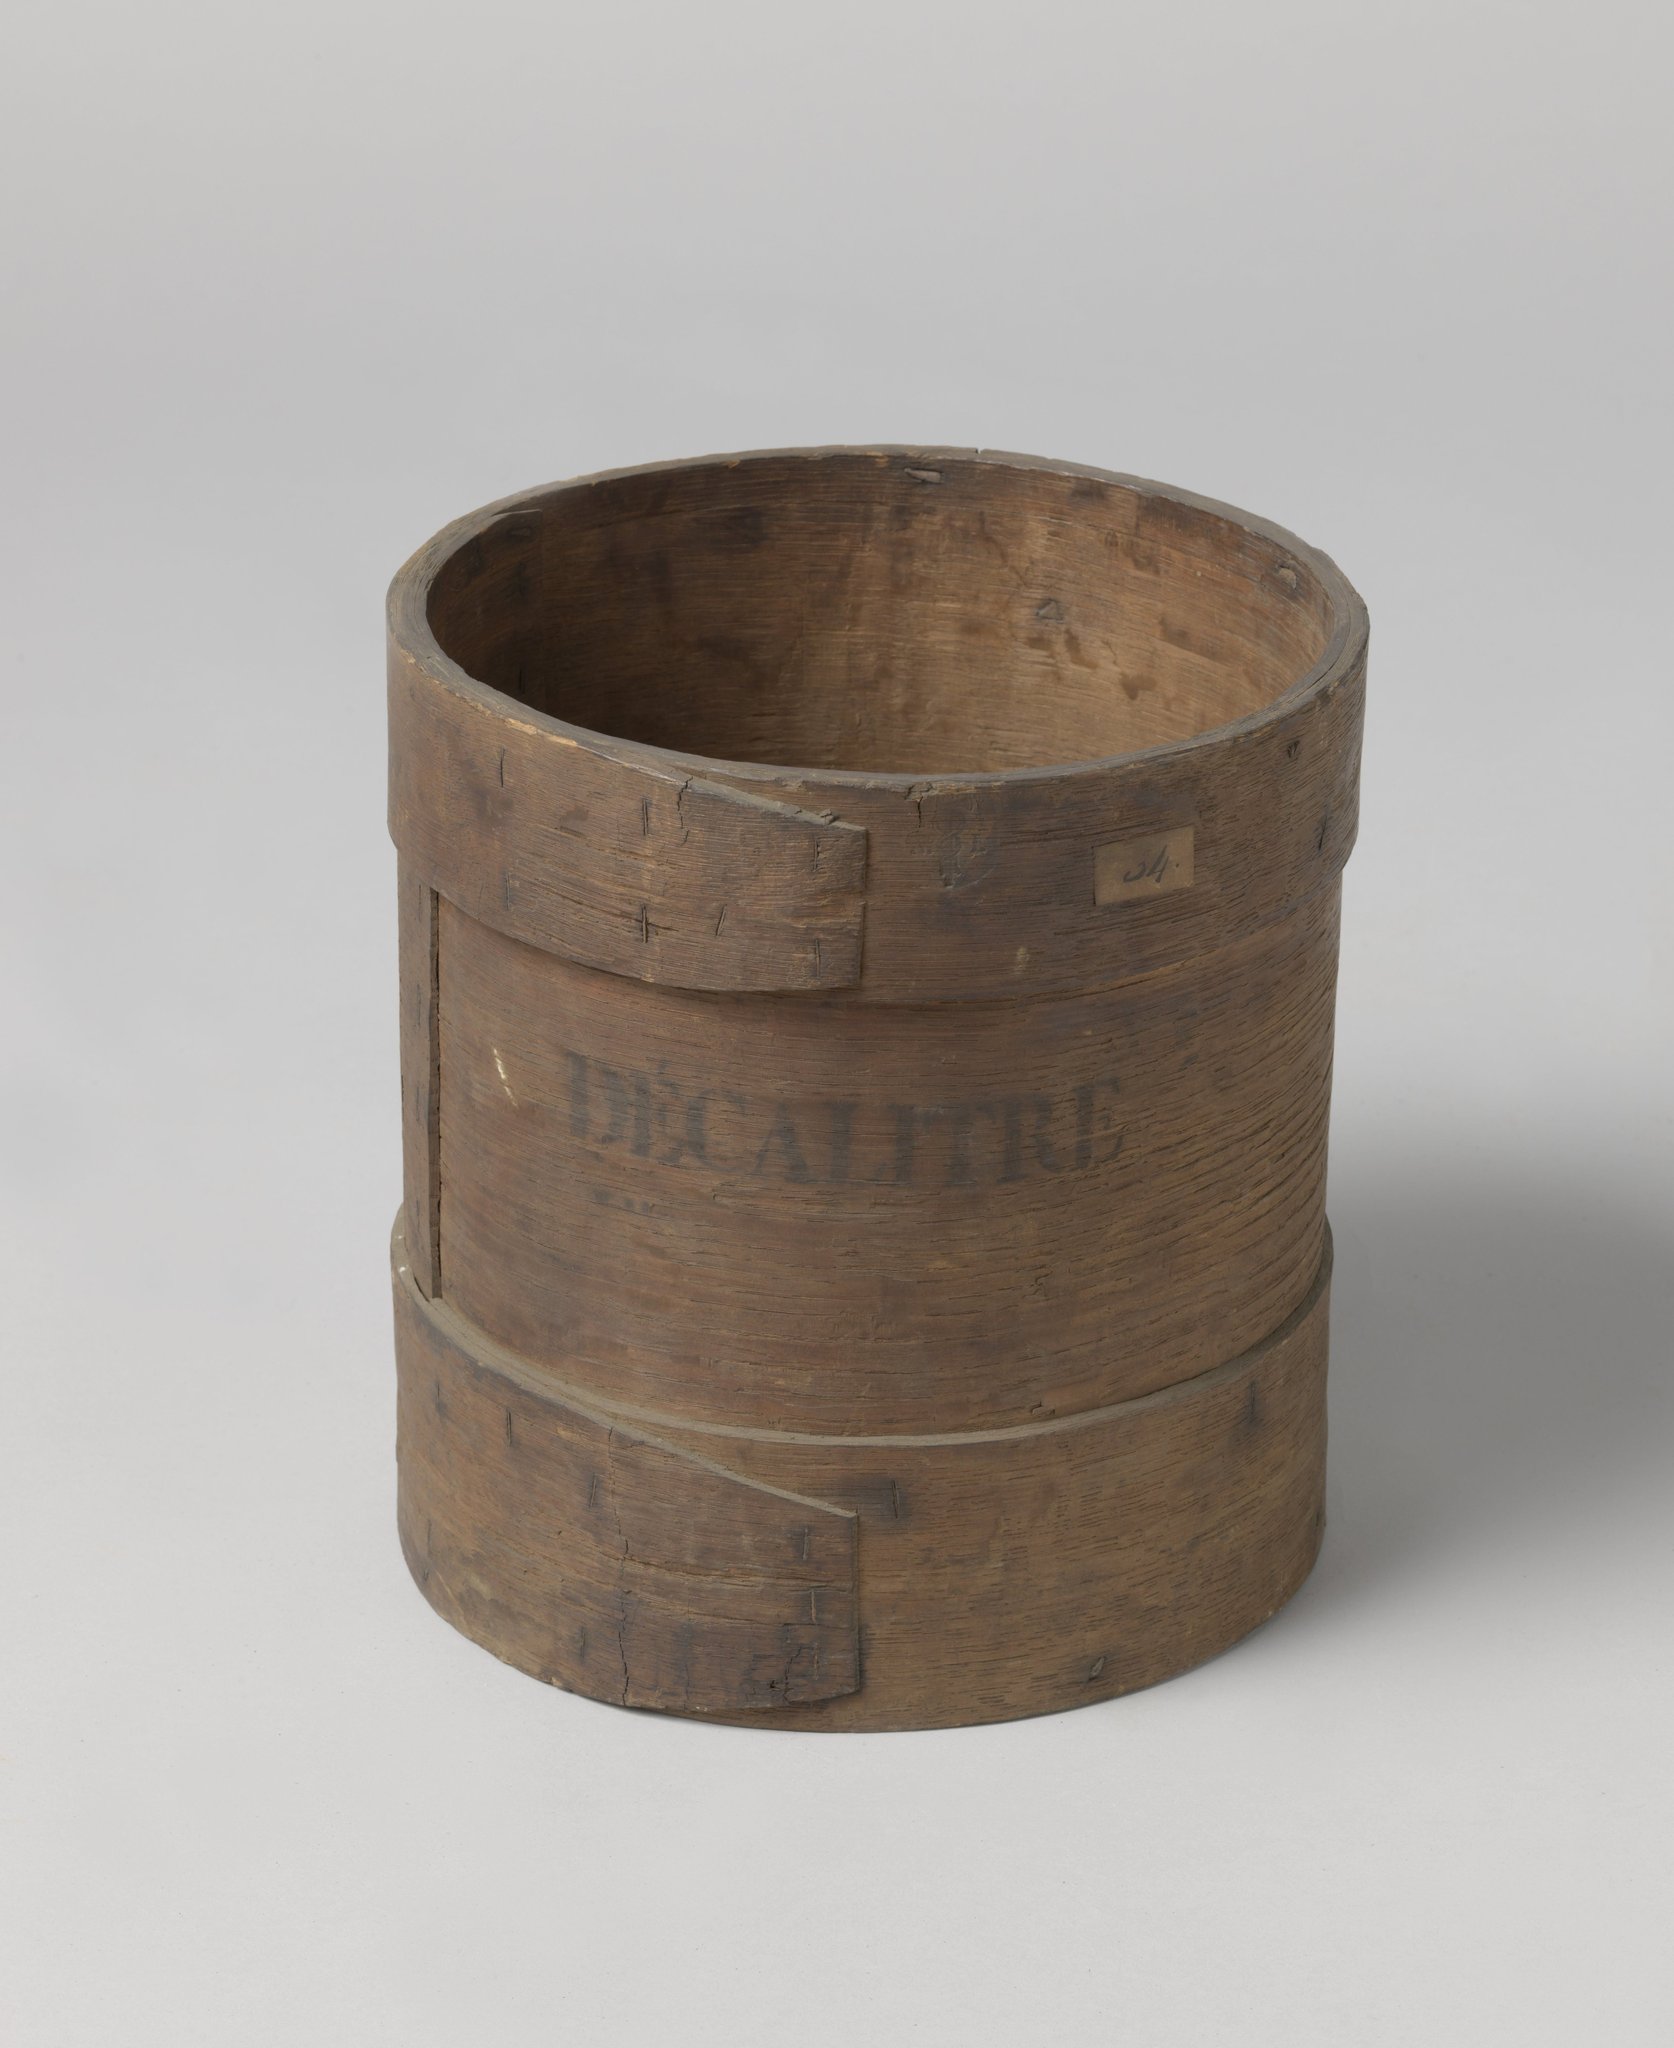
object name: inhoudsmaat droge waren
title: Inhoudsmaat van 10 liter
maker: Anonymous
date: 1823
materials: wood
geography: netherlands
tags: netherlands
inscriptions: mark: ‘R * E’, number: ‘34’, mark: ‘N * L’, seal: ‘T.F. Wolschot’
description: Spanen inhoudsmaat van 10 liter (decalitre) met houten meet- bodemrand. Aan de onderzijde v.z.v. oranje lakzegel met opschrift. V.z.v. merken en stempels.